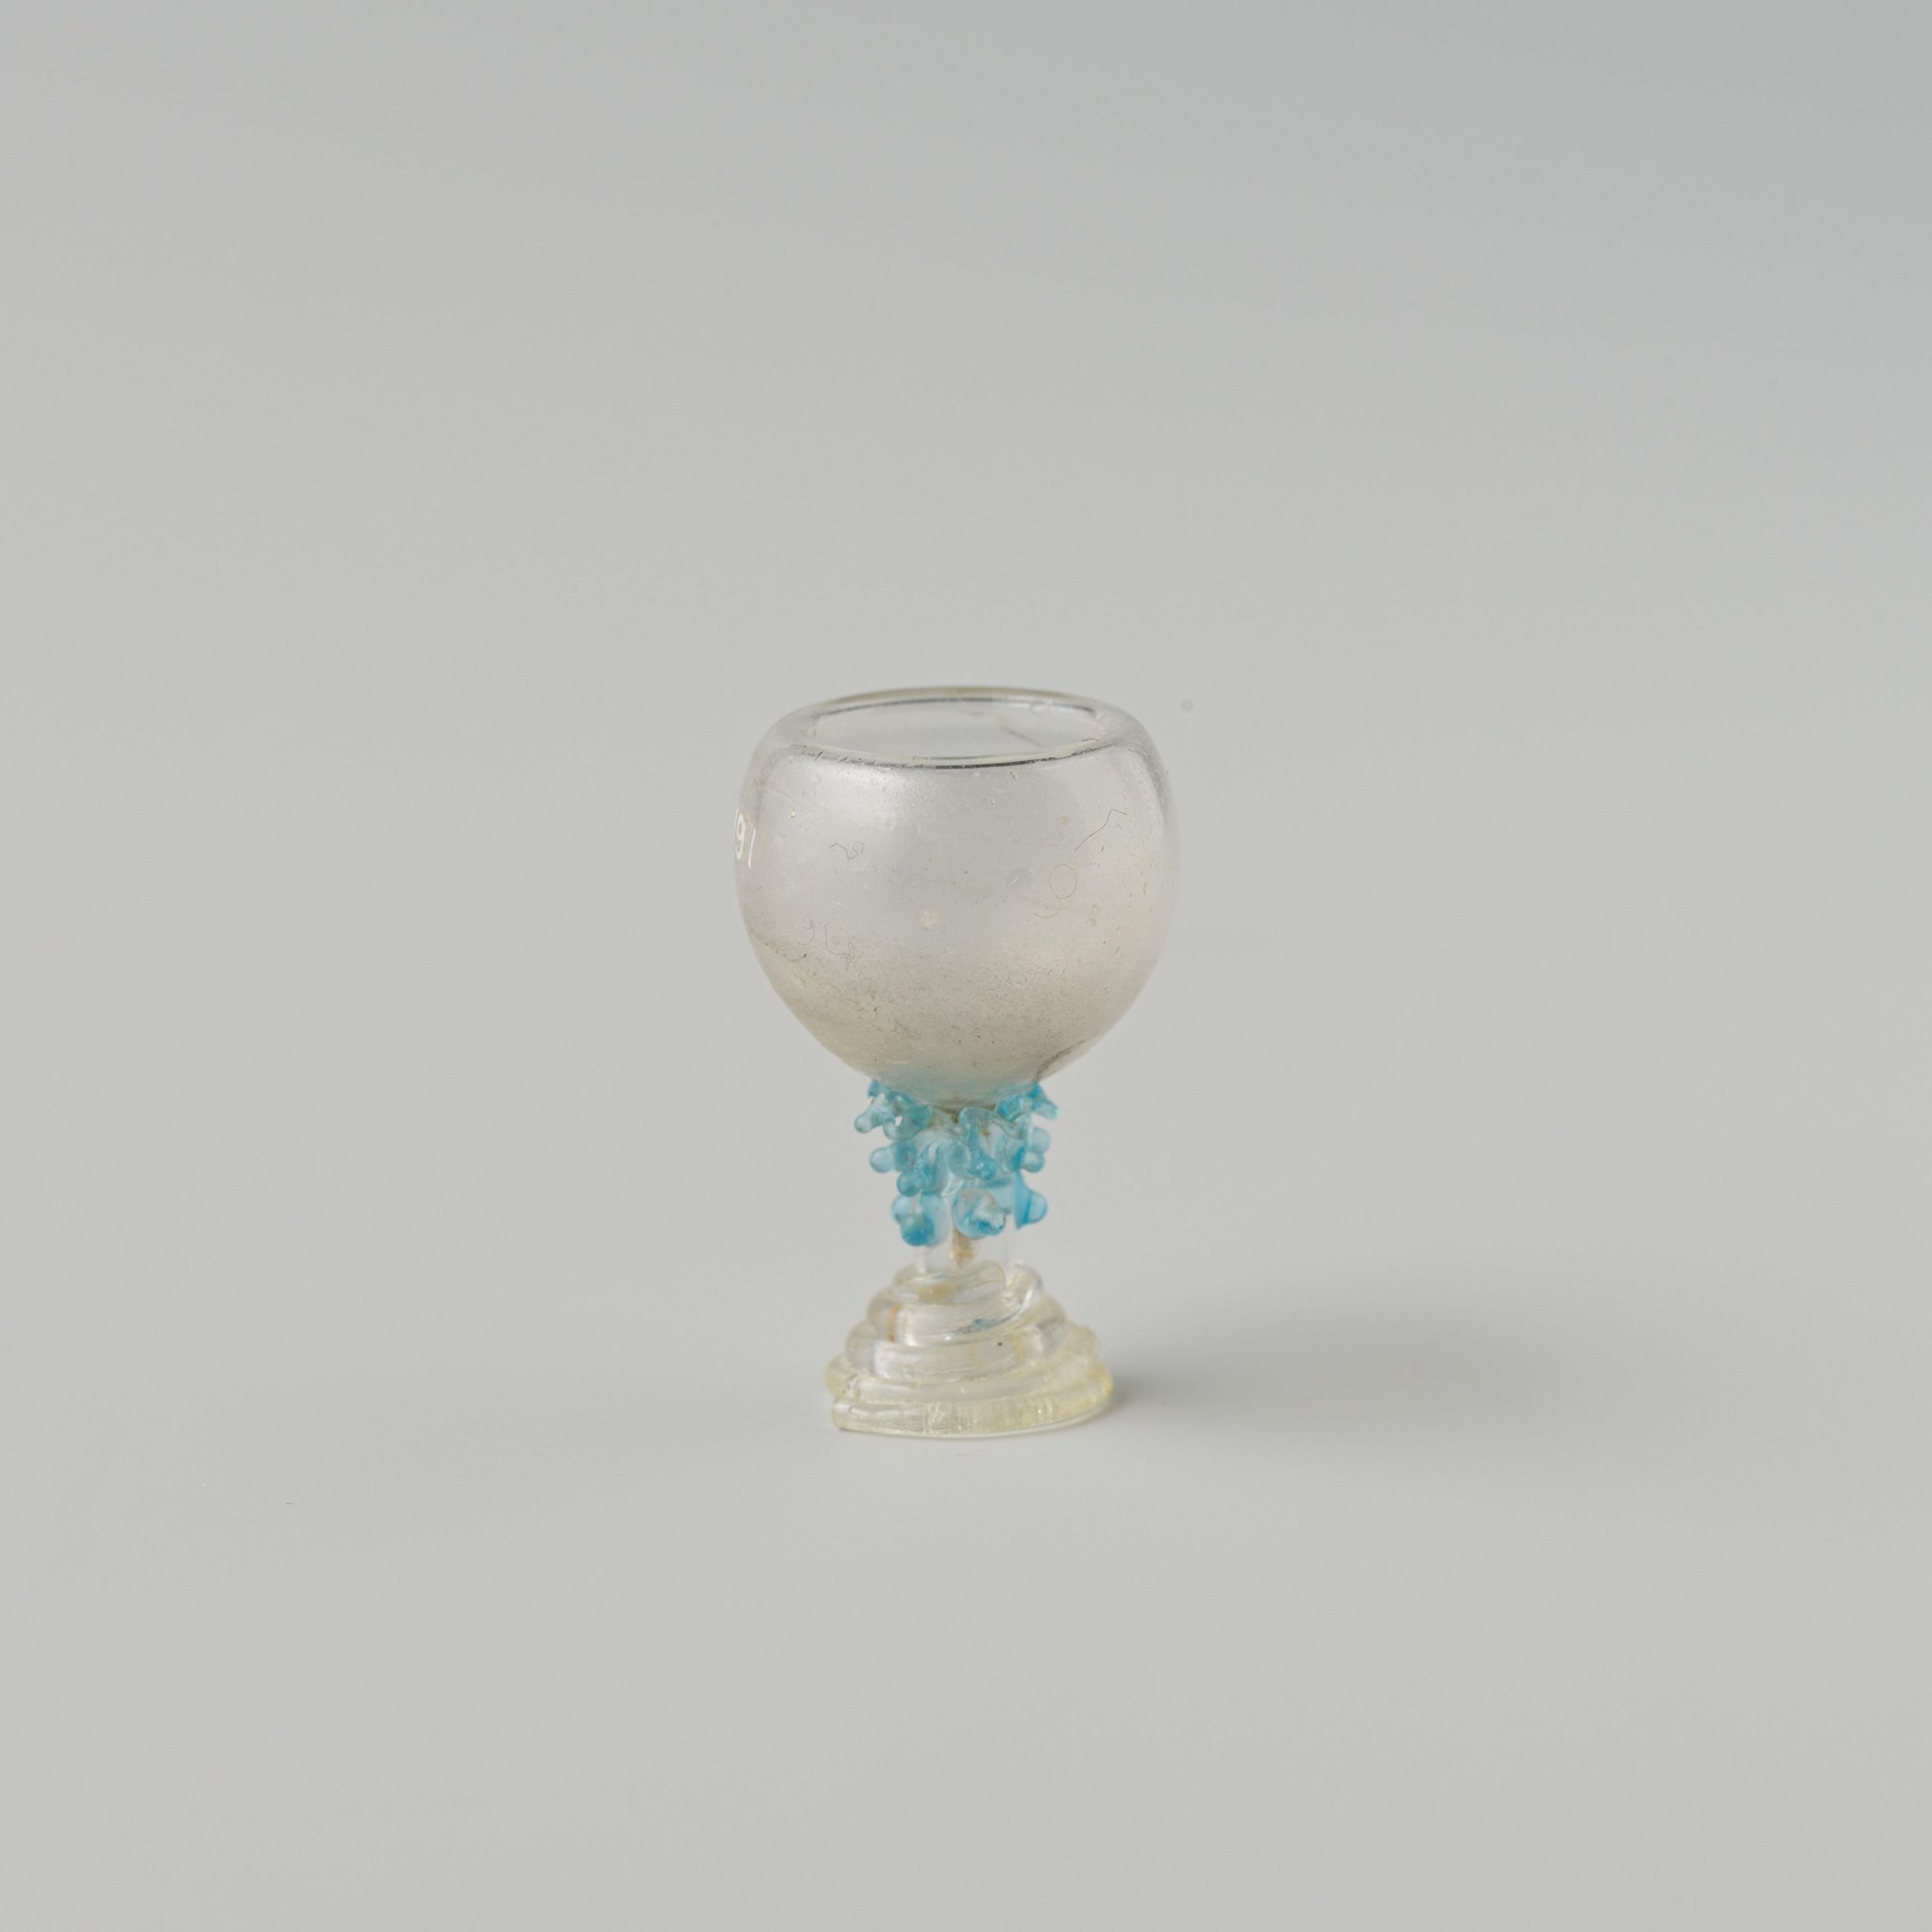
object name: miniature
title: Roemer van helder kleurloos glas met blauwe noppen op de schacht; cuppa dubbelwandig; voet van gespannen glasdraad.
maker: Anonymous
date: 1675-1710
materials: glass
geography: amsterdam